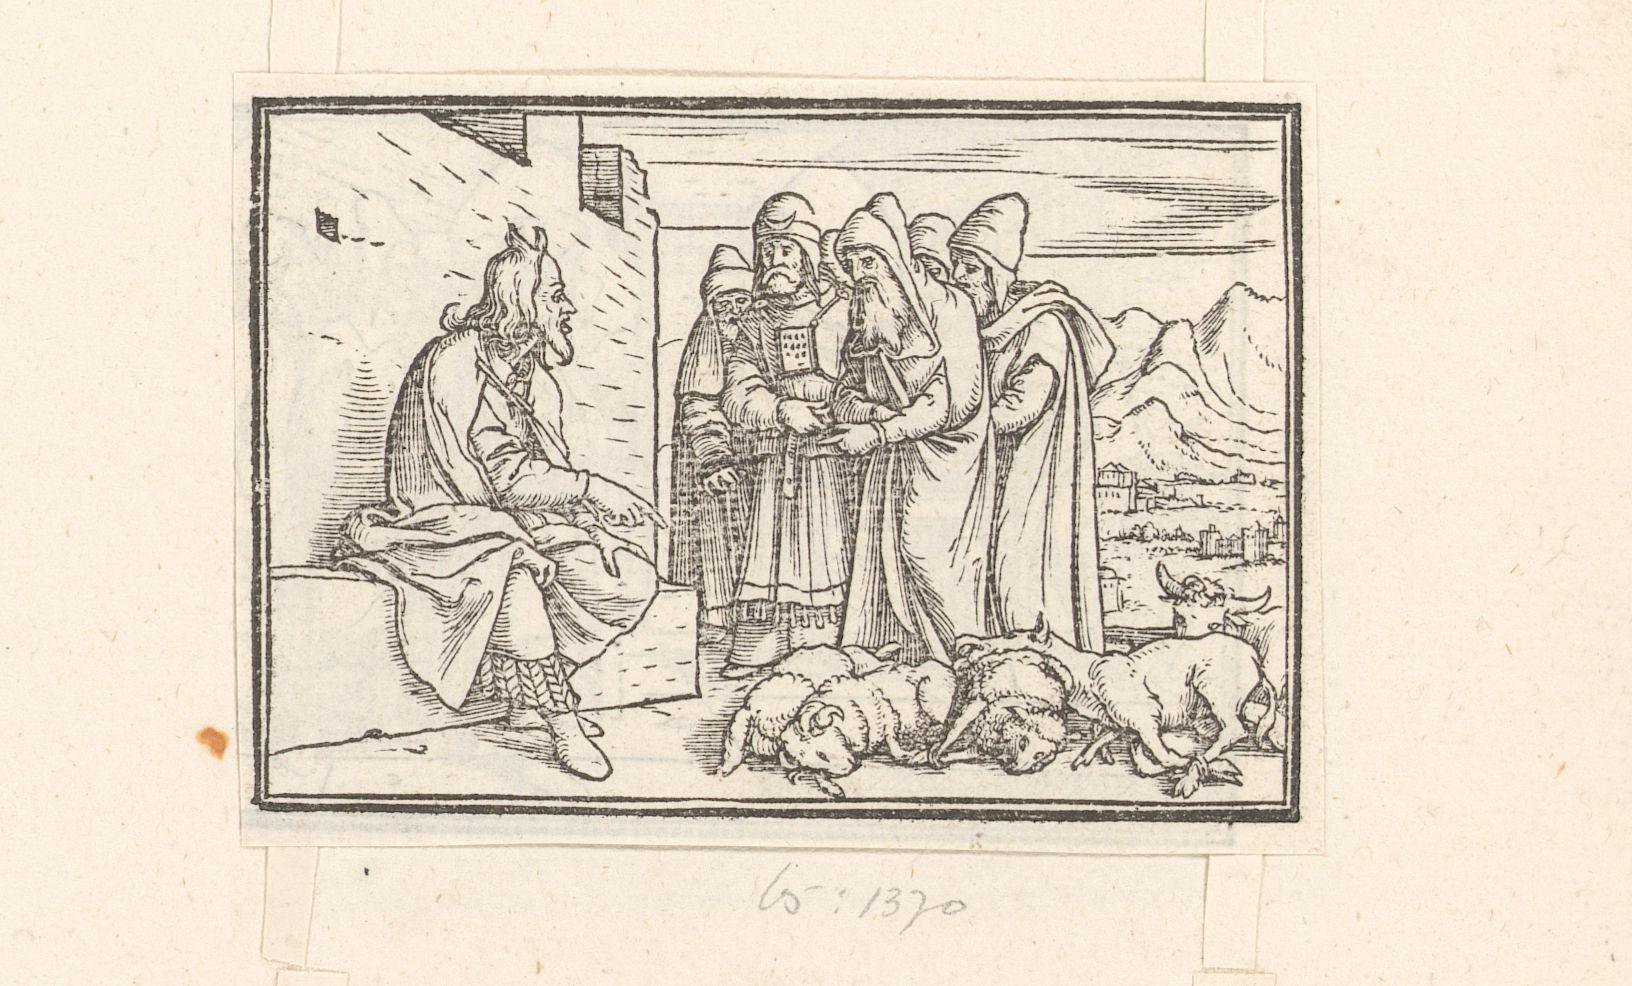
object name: album leaf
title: Mozes onderwijst de priesters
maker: veit rudolf specklin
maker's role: print maker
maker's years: -1550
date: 1538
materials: paper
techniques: woodcut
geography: switzerland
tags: moses teaching (in general)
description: Boekillustratie voor het eerst gebruikt in: Biblia Utriusque Testamenti iuxta Vulgatam Translationem, Lyon, M. en G. Trechsel (voor Hugo à Porta) 1538. Later in verschillende uitgaven opnieuw gebruikt. Deze prent vermoedelijk gebruikt in één van de uitgaven uitgegeven en/of gedrukt door Jean Frellon, Lyon.